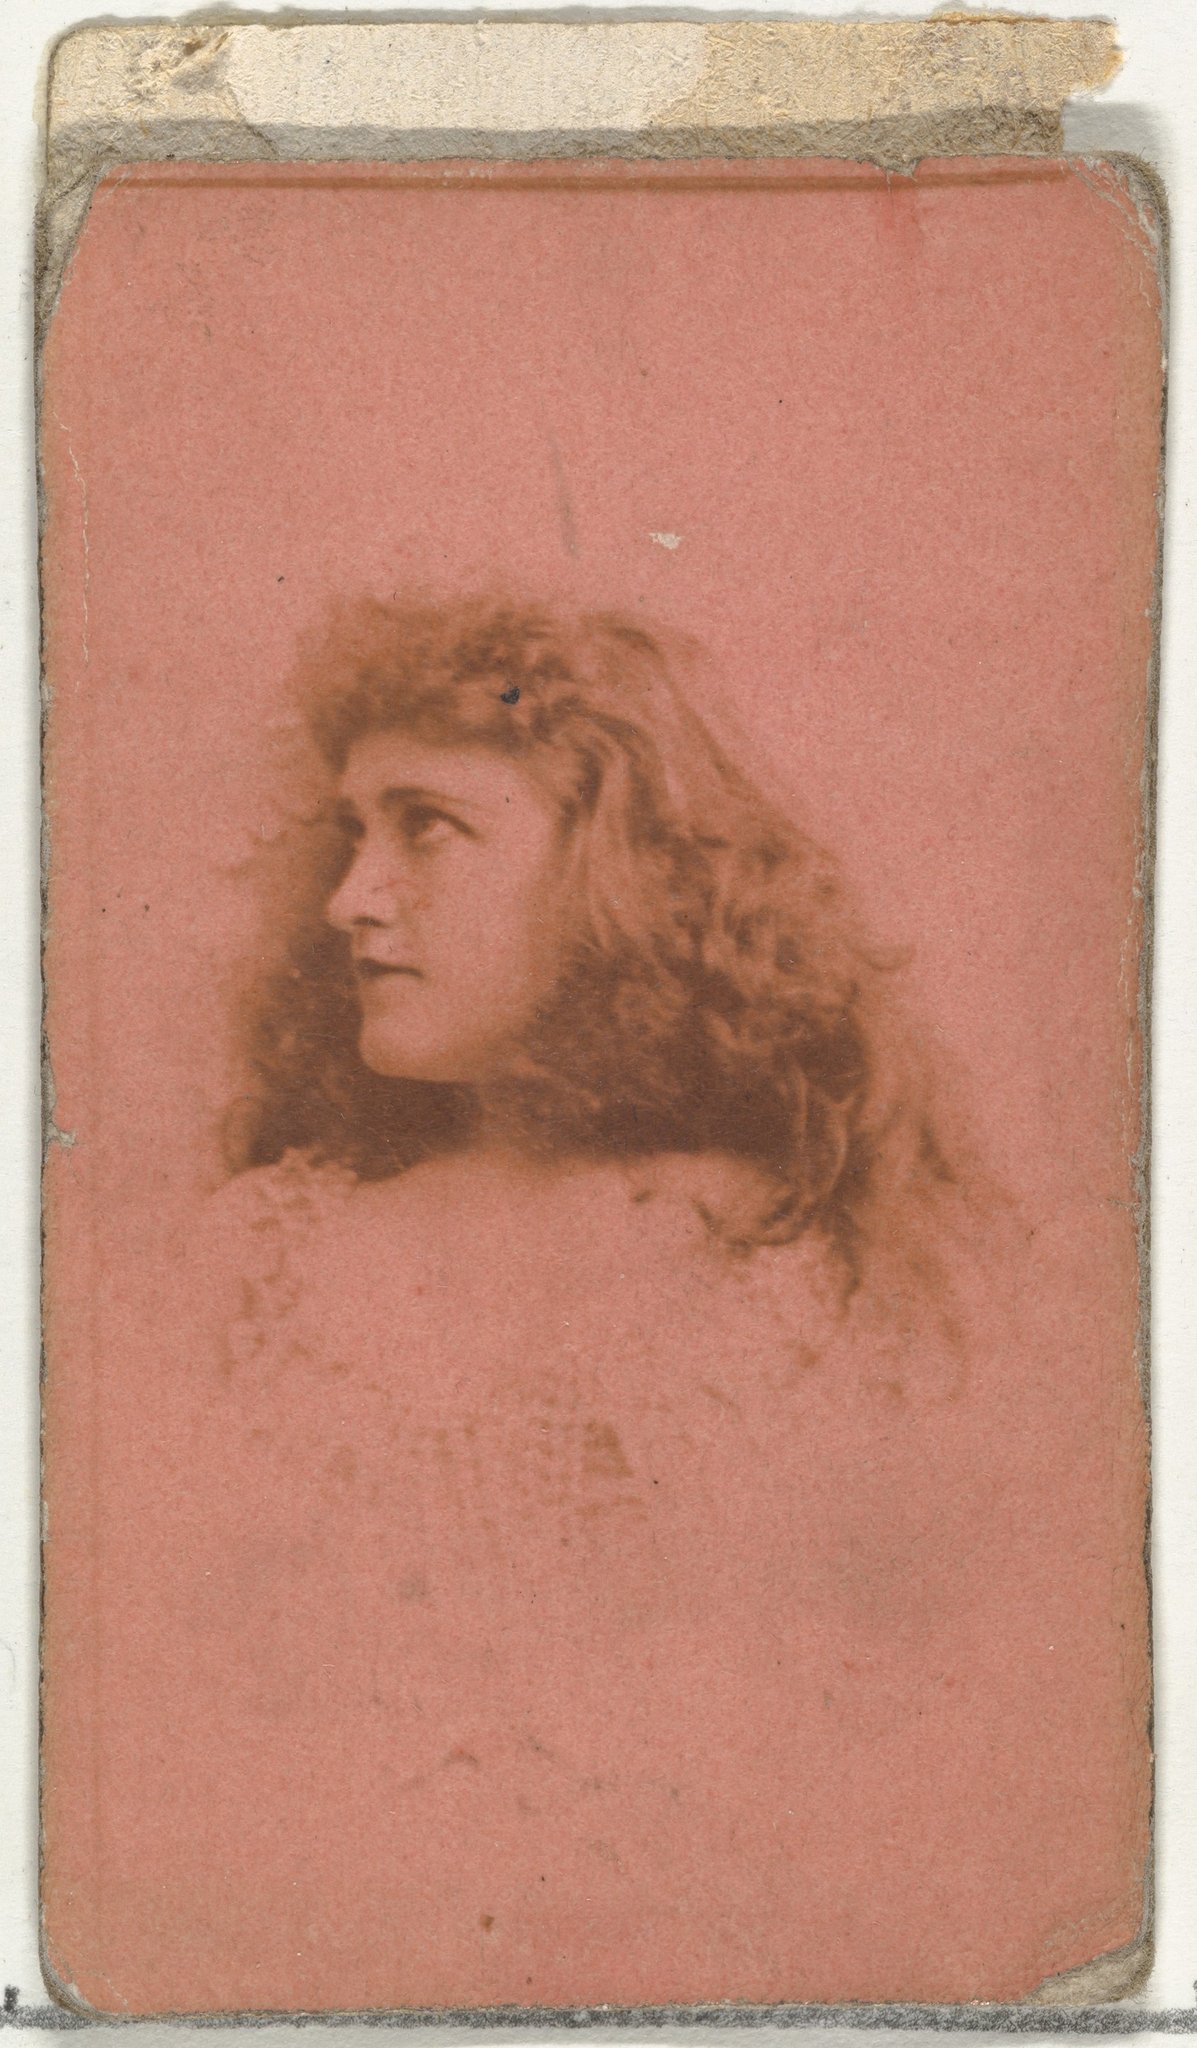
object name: photograph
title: [Actress in profile], from the Actors and Actresses series (N145-8) issued by Duke Sons & Co. to promote Duke Cigarettes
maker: w. duke, sons & co.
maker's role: publisher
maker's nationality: american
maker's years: 1870-1920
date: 1891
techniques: albumen silver print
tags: women,actresses